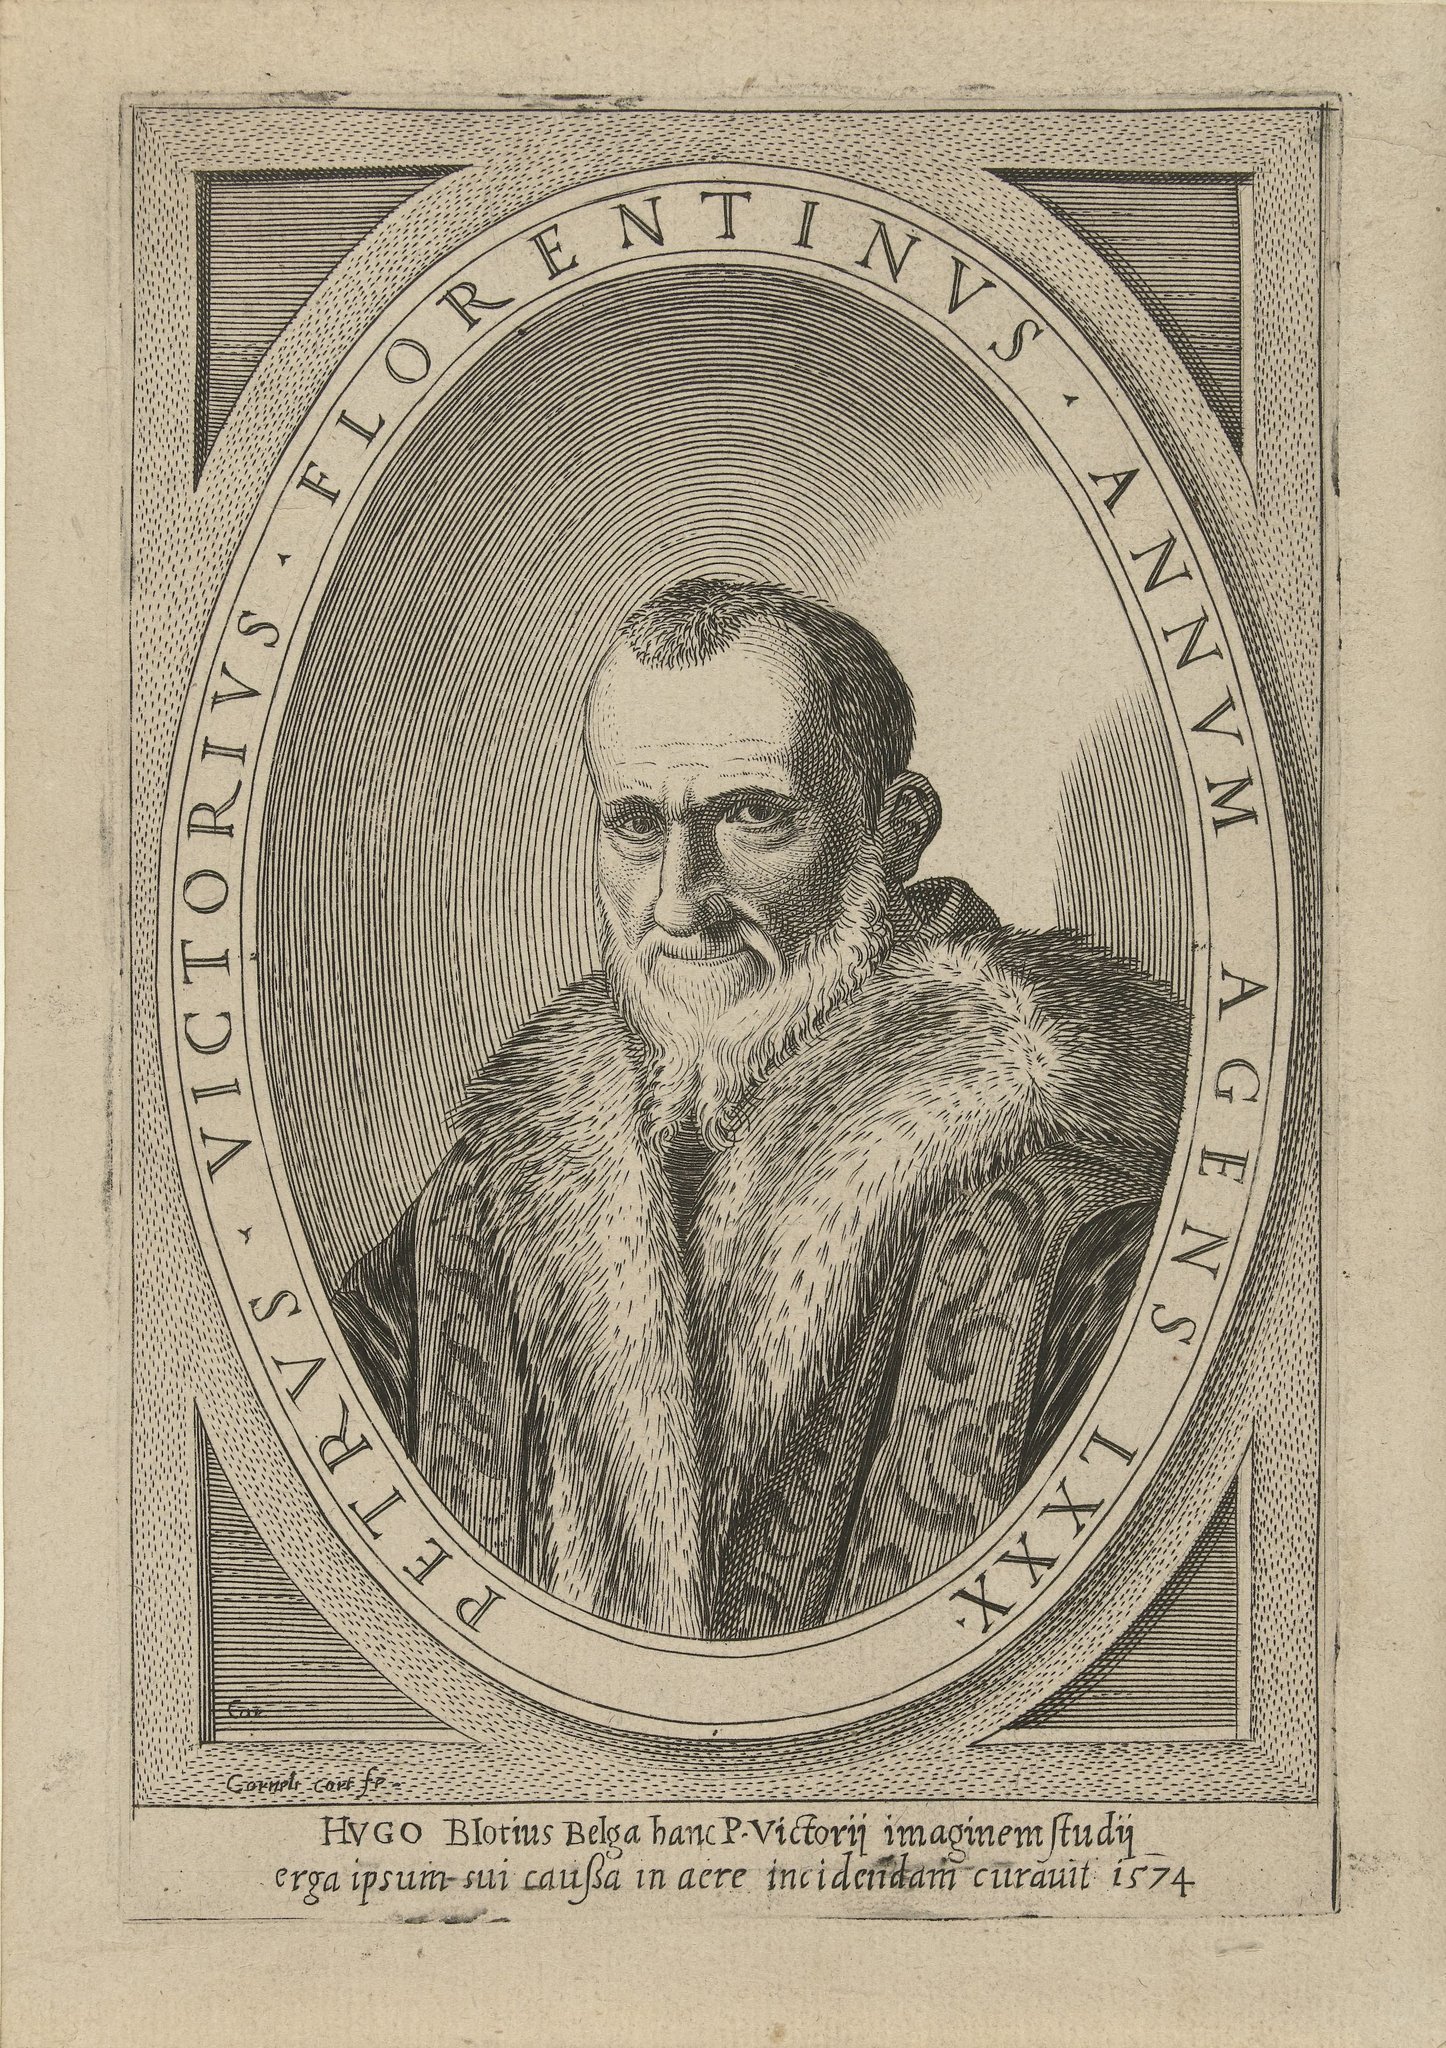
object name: print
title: Portret van Pietro Vettori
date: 1574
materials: paper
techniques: engraving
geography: rome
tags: filoloog, humanist, piero vettòri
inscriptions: collector's mark: Lugt 2228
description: Portret van Pietro Vettori op 80-jarige leeftijd, in ovaal met randschrift.